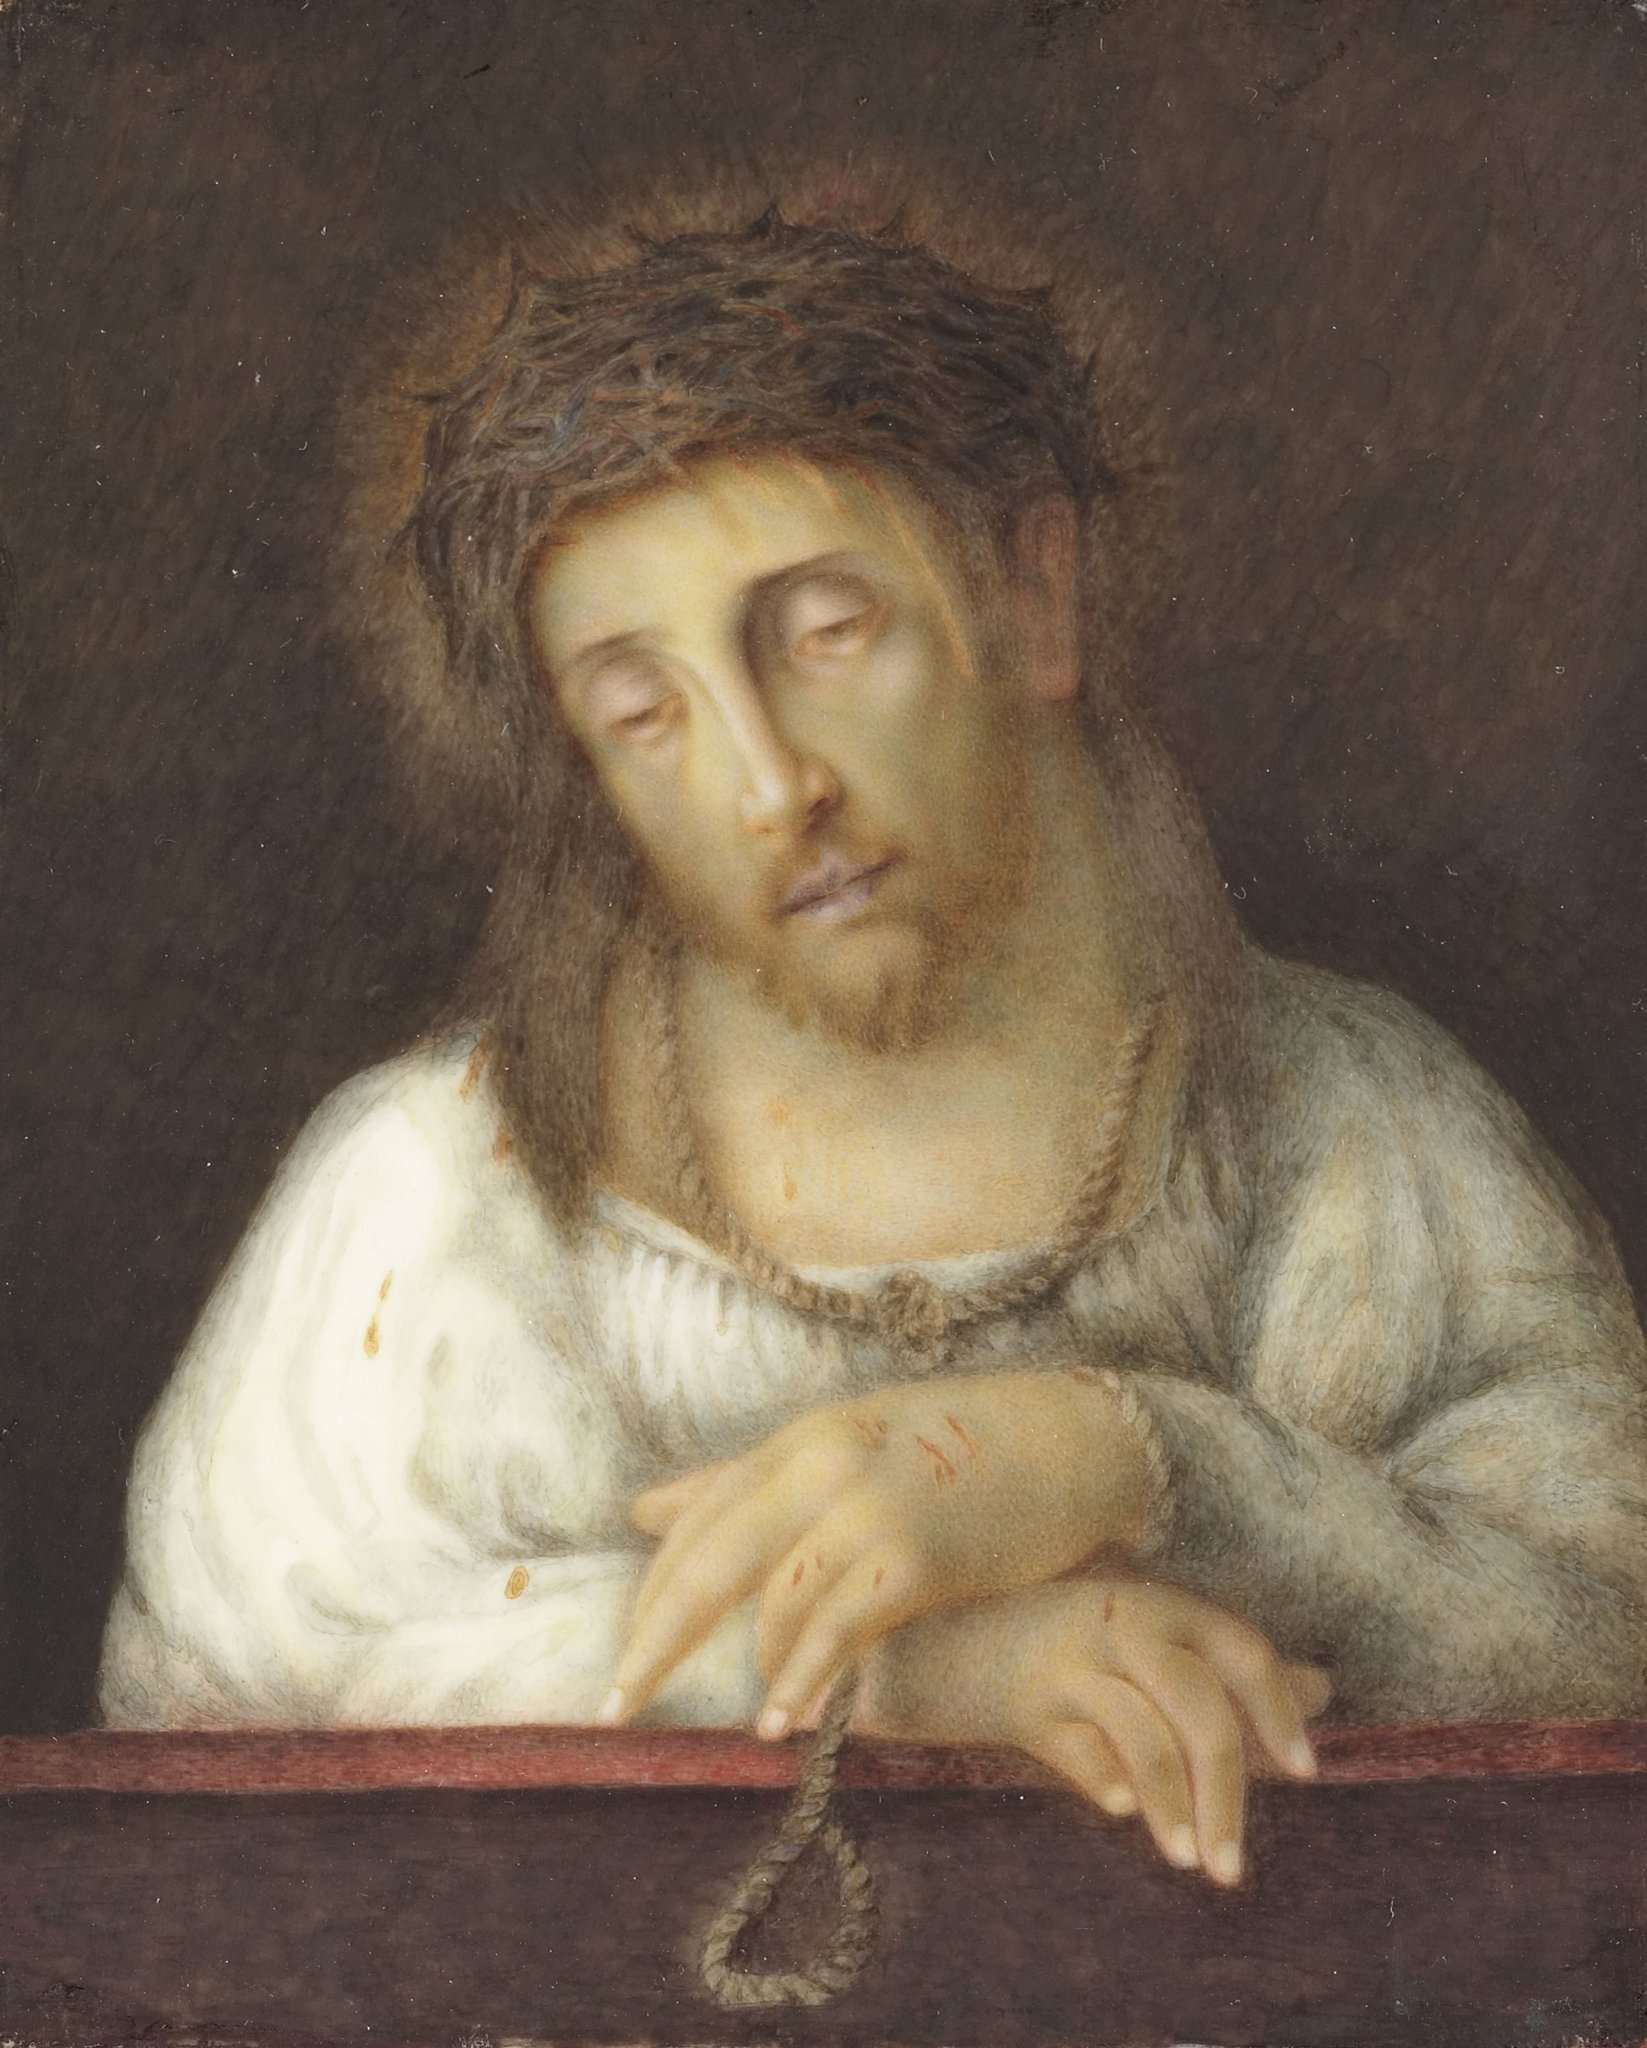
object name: painting, miniature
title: Christus als man van smarten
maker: ida jacoba reigersman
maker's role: miniatuurschilder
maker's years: 1755-1829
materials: ivory, metal, wood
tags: louis napoleon (king of holland), man of sorrows, 'imago pietatis', 'erbärmdebild', 'schmerzensmann'; the upright christ showing his wounds, usually bearing the crown of thorns, and accompanied by the instruments of the passion, standing or sitting in his tomb, holland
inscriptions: signature: ‘Lz’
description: Christus als man van smarten. Halffiguur, leunend met de handen op een balustrade. Naar Correggio. Door de kunstenaar in 1809 aangeboden aan koning Lodewijk Napoleon.